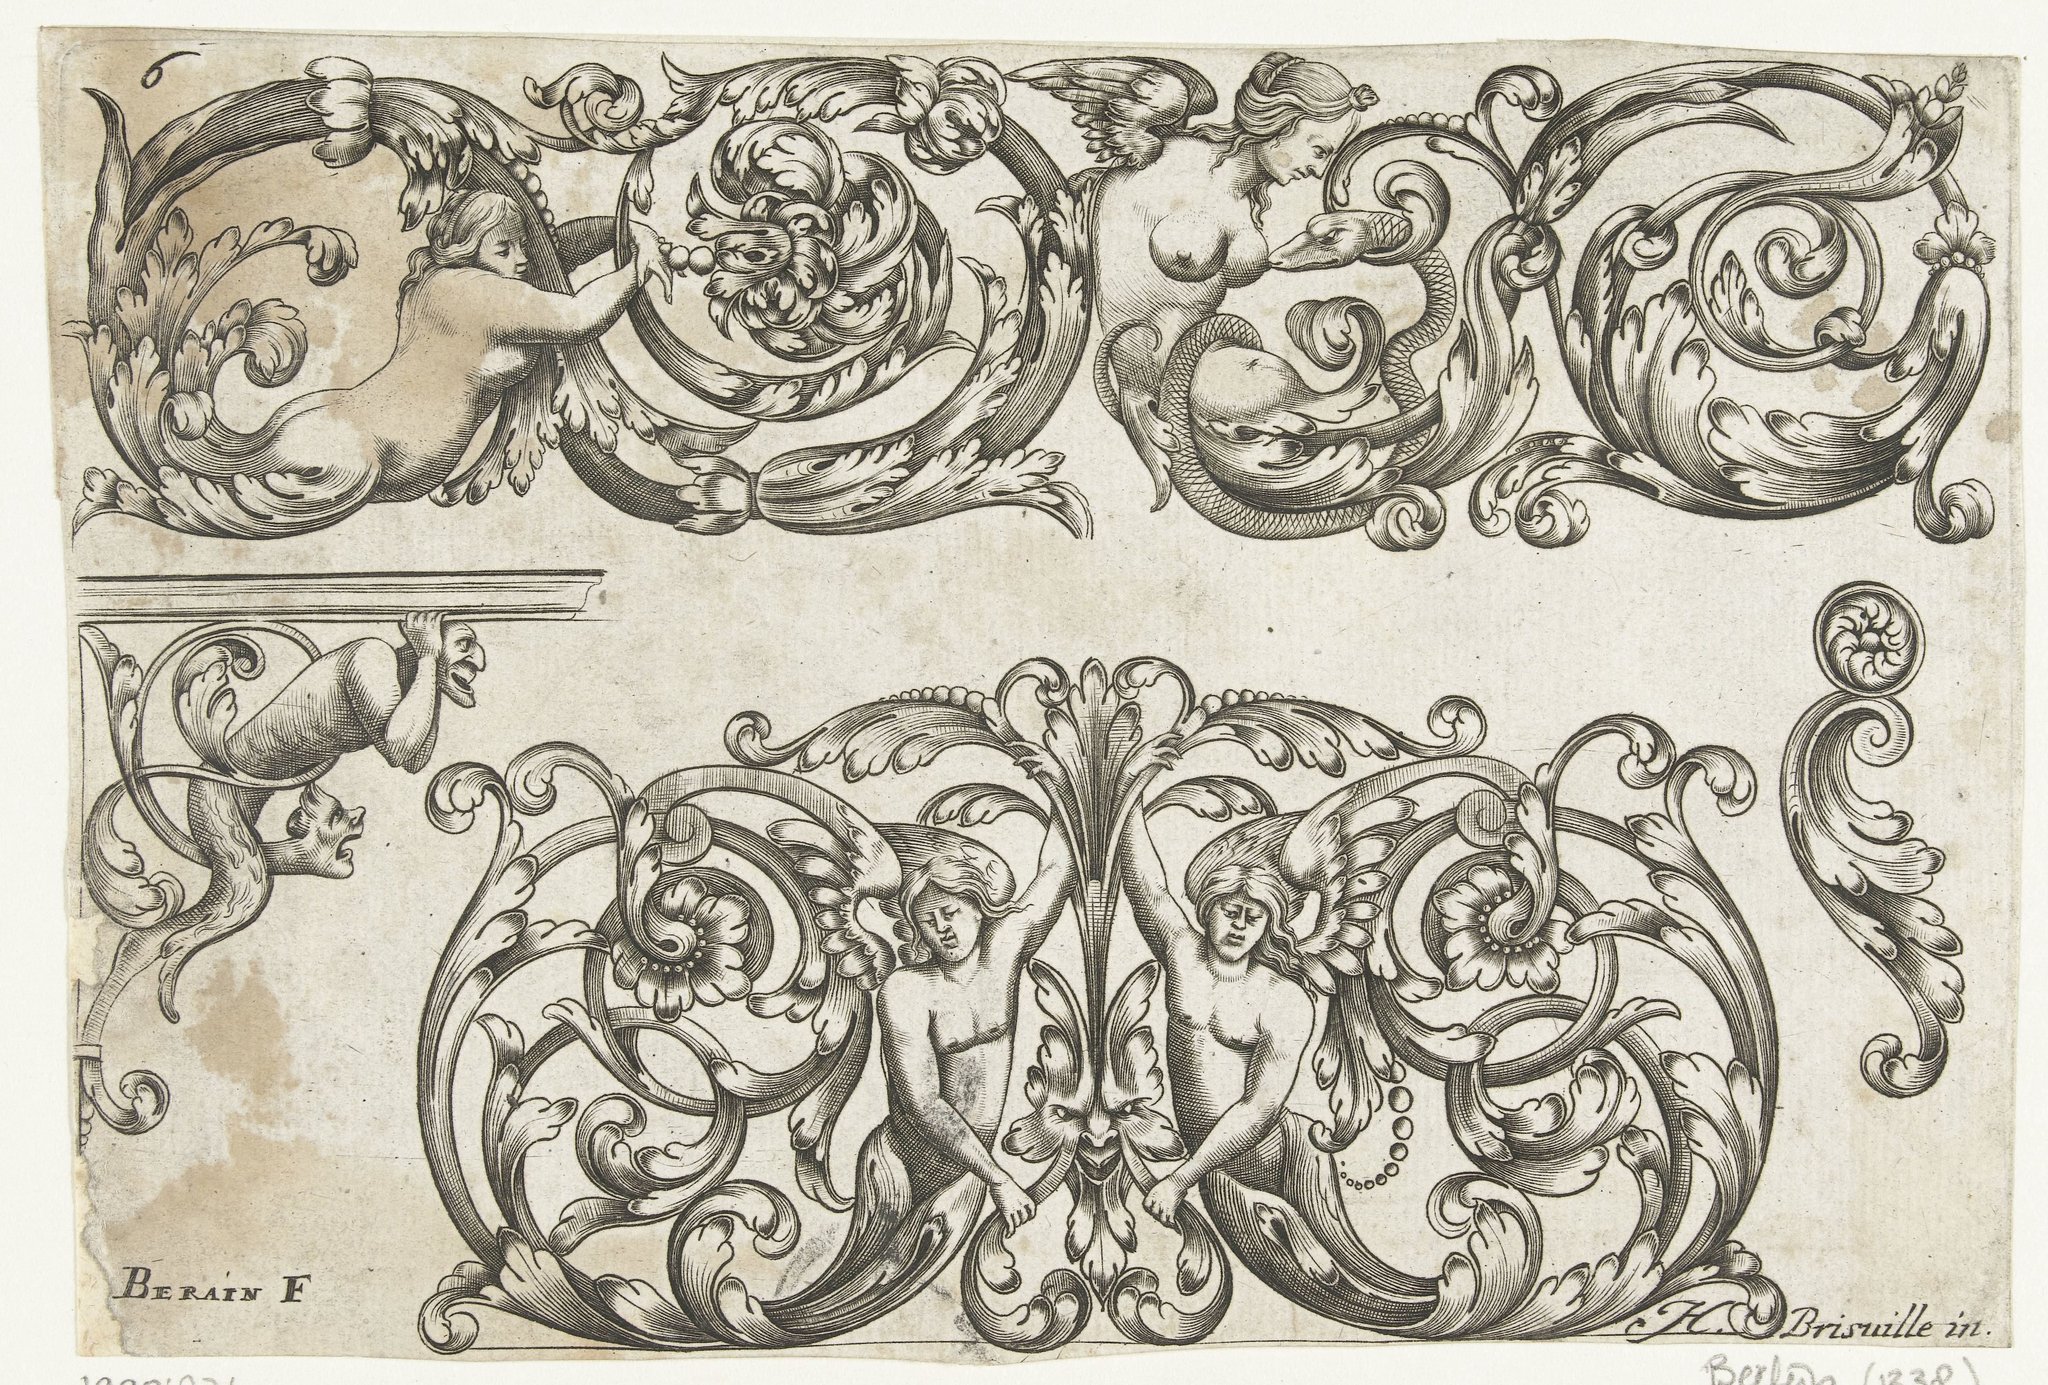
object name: print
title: Diverses Pièces de Serruriers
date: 1662-1711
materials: paper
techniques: engraving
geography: paris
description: Het fries bovenaan bestaat uit bladranken met in het midden het bovenlichaam van een gevleugelde vrouw, die in de borst gebeten wordt door een slang. Linksonder is een console met een grotesk figuur van de zijkant afgebeeld, het symmetrische voorbeeld voor sleutelgatplaten daarnaast is geflankeerd door twee gevleugelde vrouwen. In de hoek rechtsonder is een detail voor smeedijzerwerk aangebracht. Blad 6 uit serie van titelblad, blad met opdracht en 14 bladen met beslag en smeedwerk, sleutelgatplaten, sleutels, deurkloppers en deurknoppen. Tweede editie.